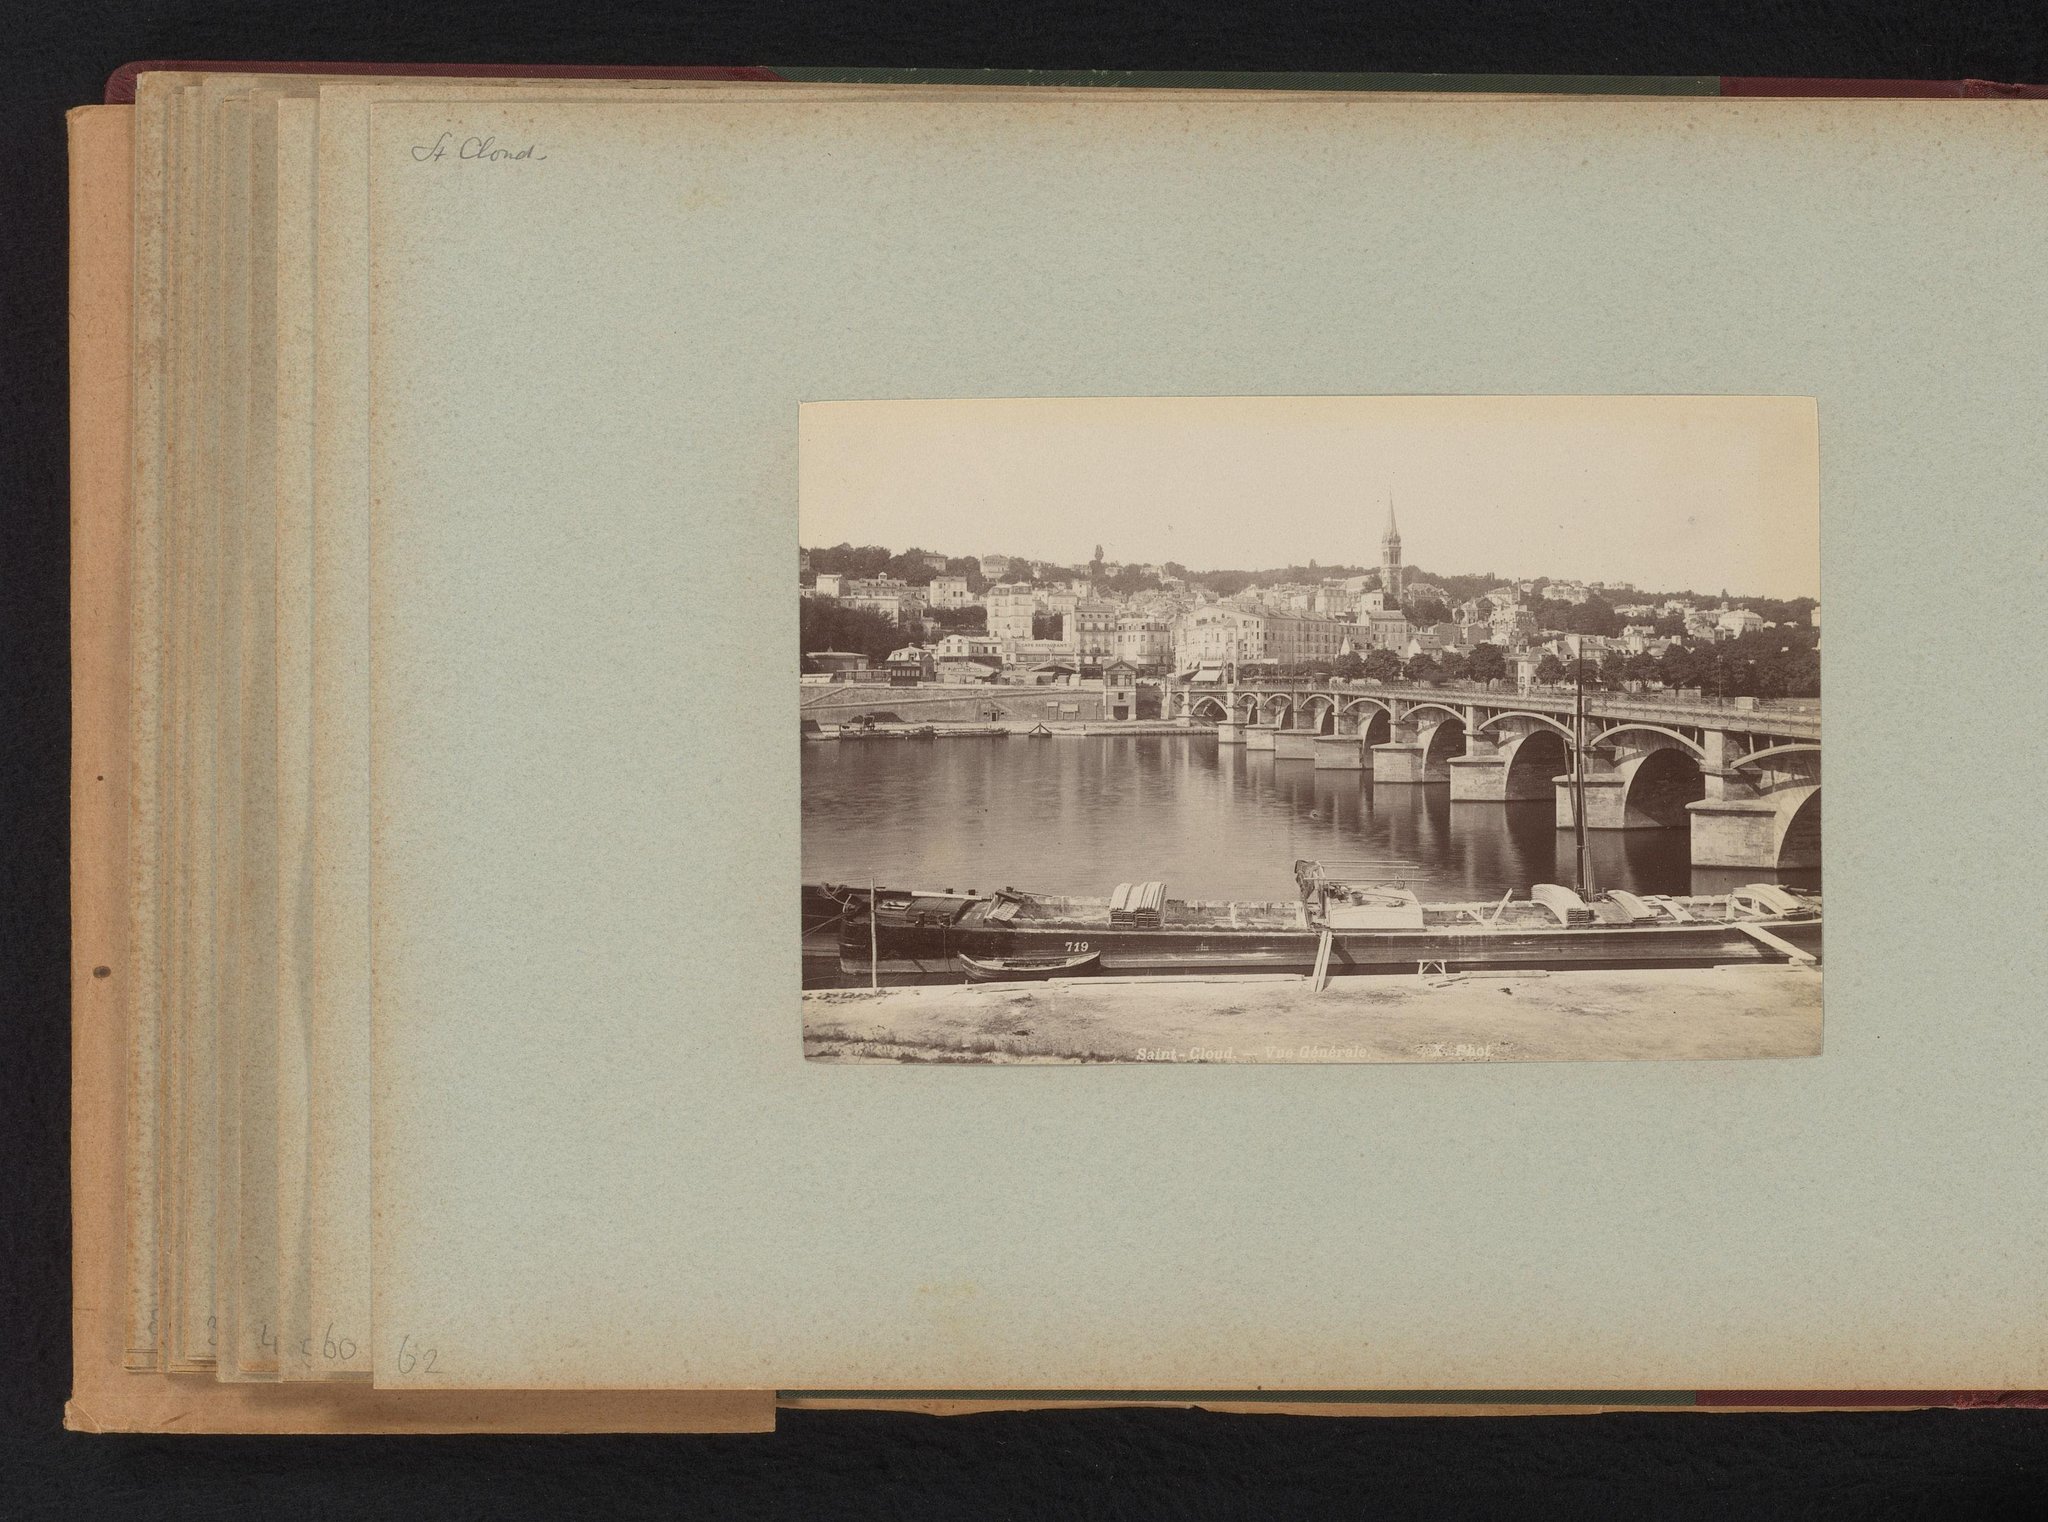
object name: photograph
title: Vue générale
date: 1887-1900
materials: paper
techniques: albumen print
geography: saint-cloud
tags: city-view in general; 'veduta', bridge in city across river, canal, etc.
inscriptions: inscription: ‘St Cloud.’, number: ‘719’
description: Tussen 1887 en ca. 1900 werkten Neurdein frères onder andere onder de naam 'X phot.'.